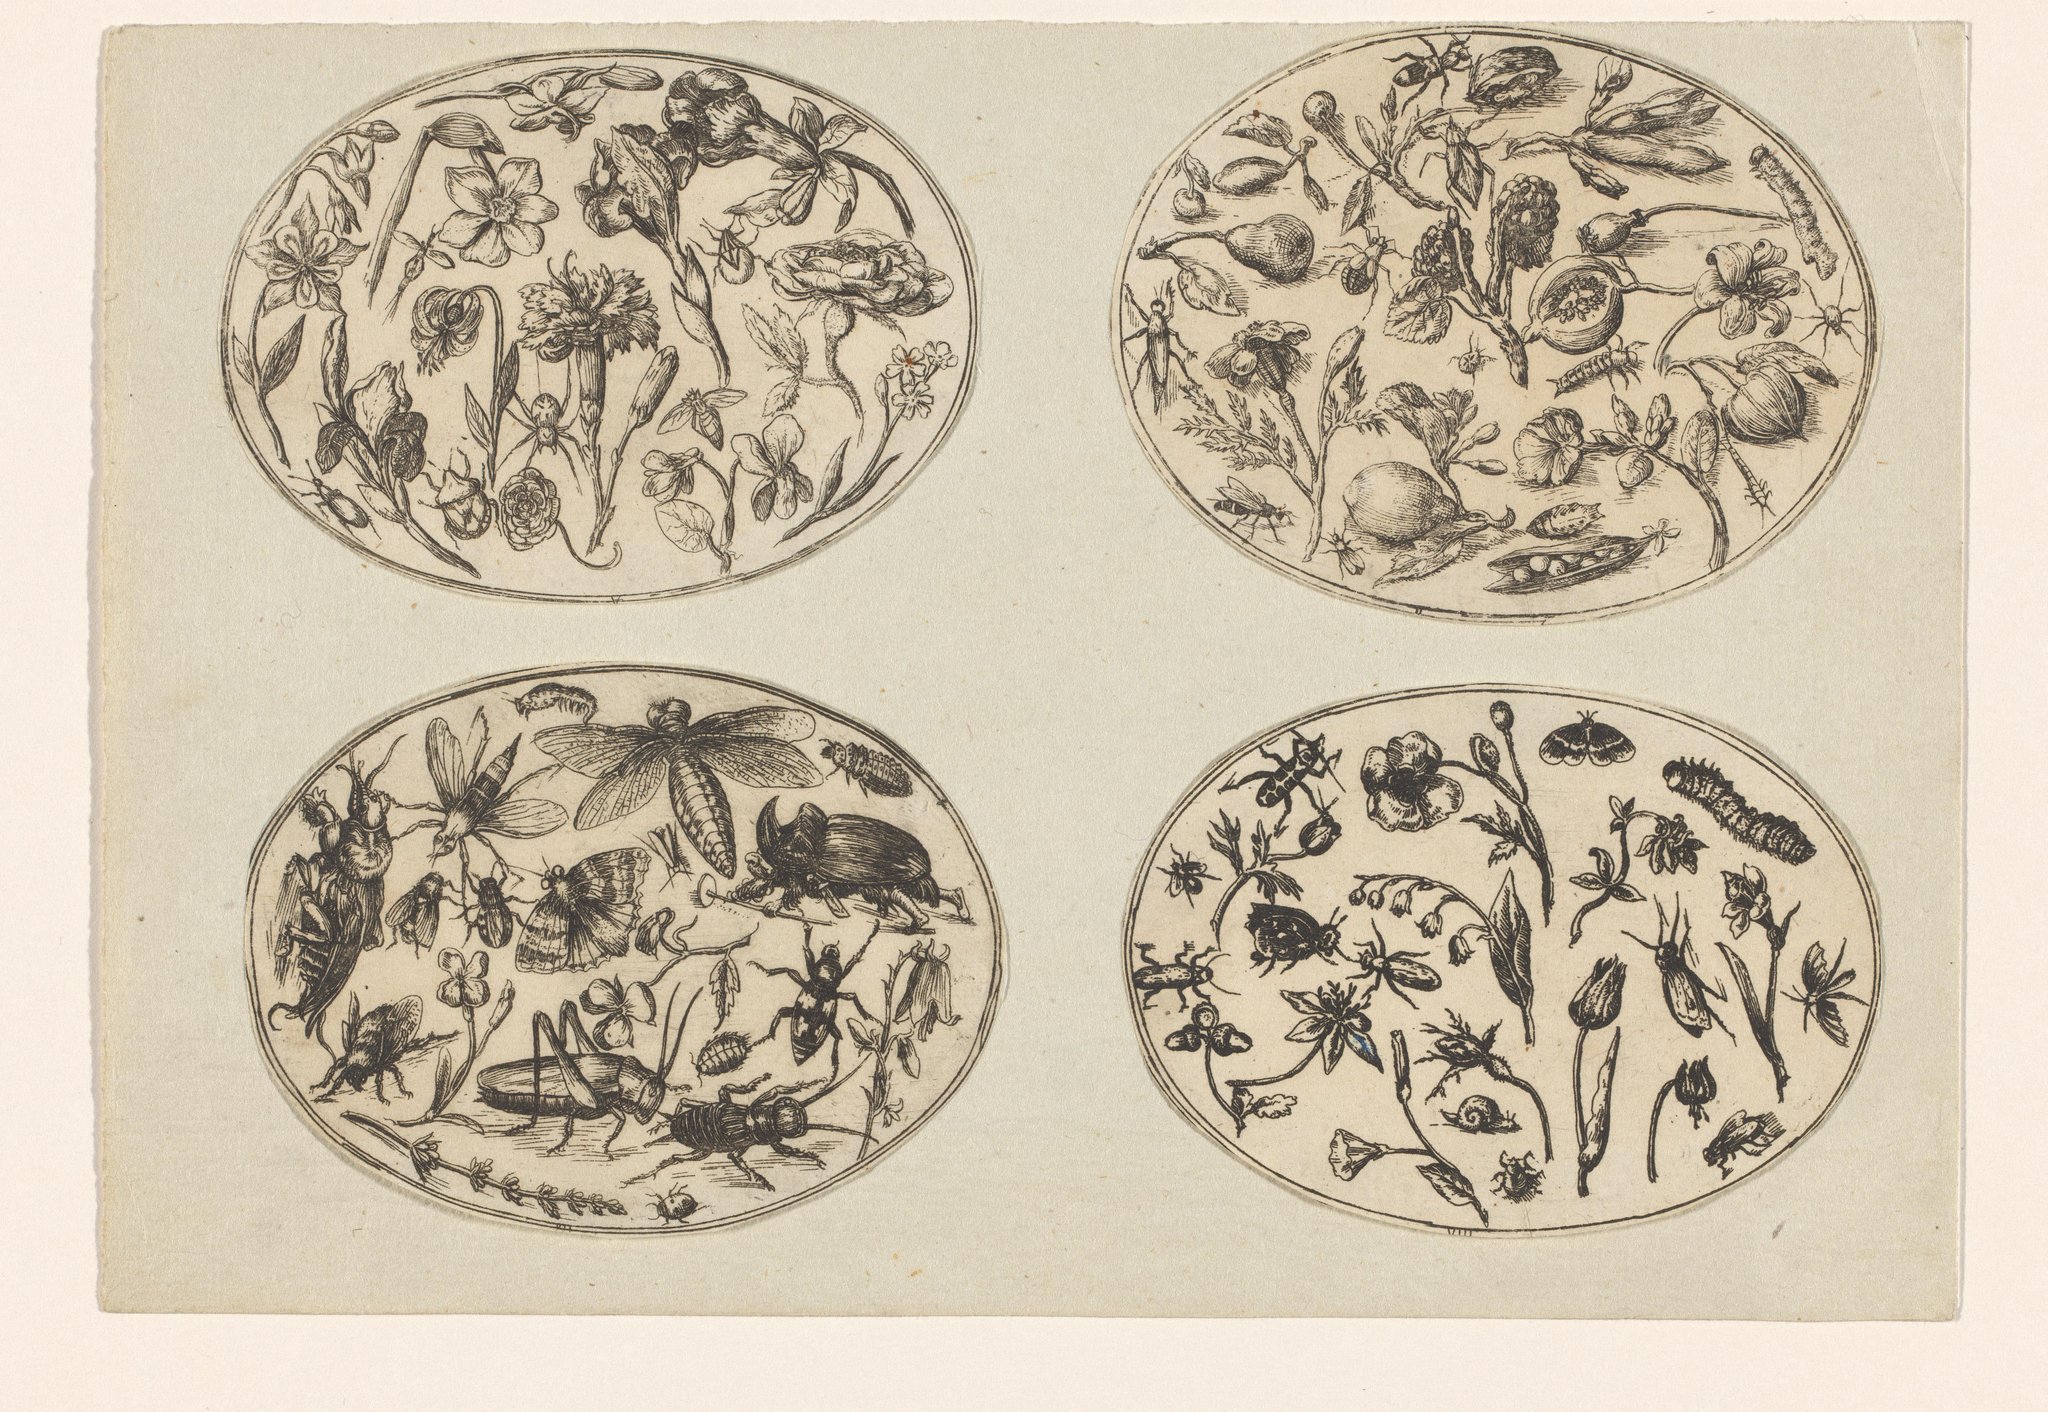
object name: ornament print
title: Neues Frücht-vnd Blumenbüchlein. Allen Künstlern dienstlich.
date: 1650-1666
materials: paper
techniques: etching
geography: nuremberg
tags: ornament derived from animal forms, insects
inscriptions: collector's mark: Lugt 2228, collector's mark: Lugt 2760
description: Paul Fürst, Neues Frücht-vnd Blumenbüchlein. Allen Künstlern dienstlich. Een van zeven prenten (RP-P-2020-235 t/m 241), inclusief titelblad uit een reeks van acht met weergaven van bloemen, vruchten, noten paddenstoelen en insecten.